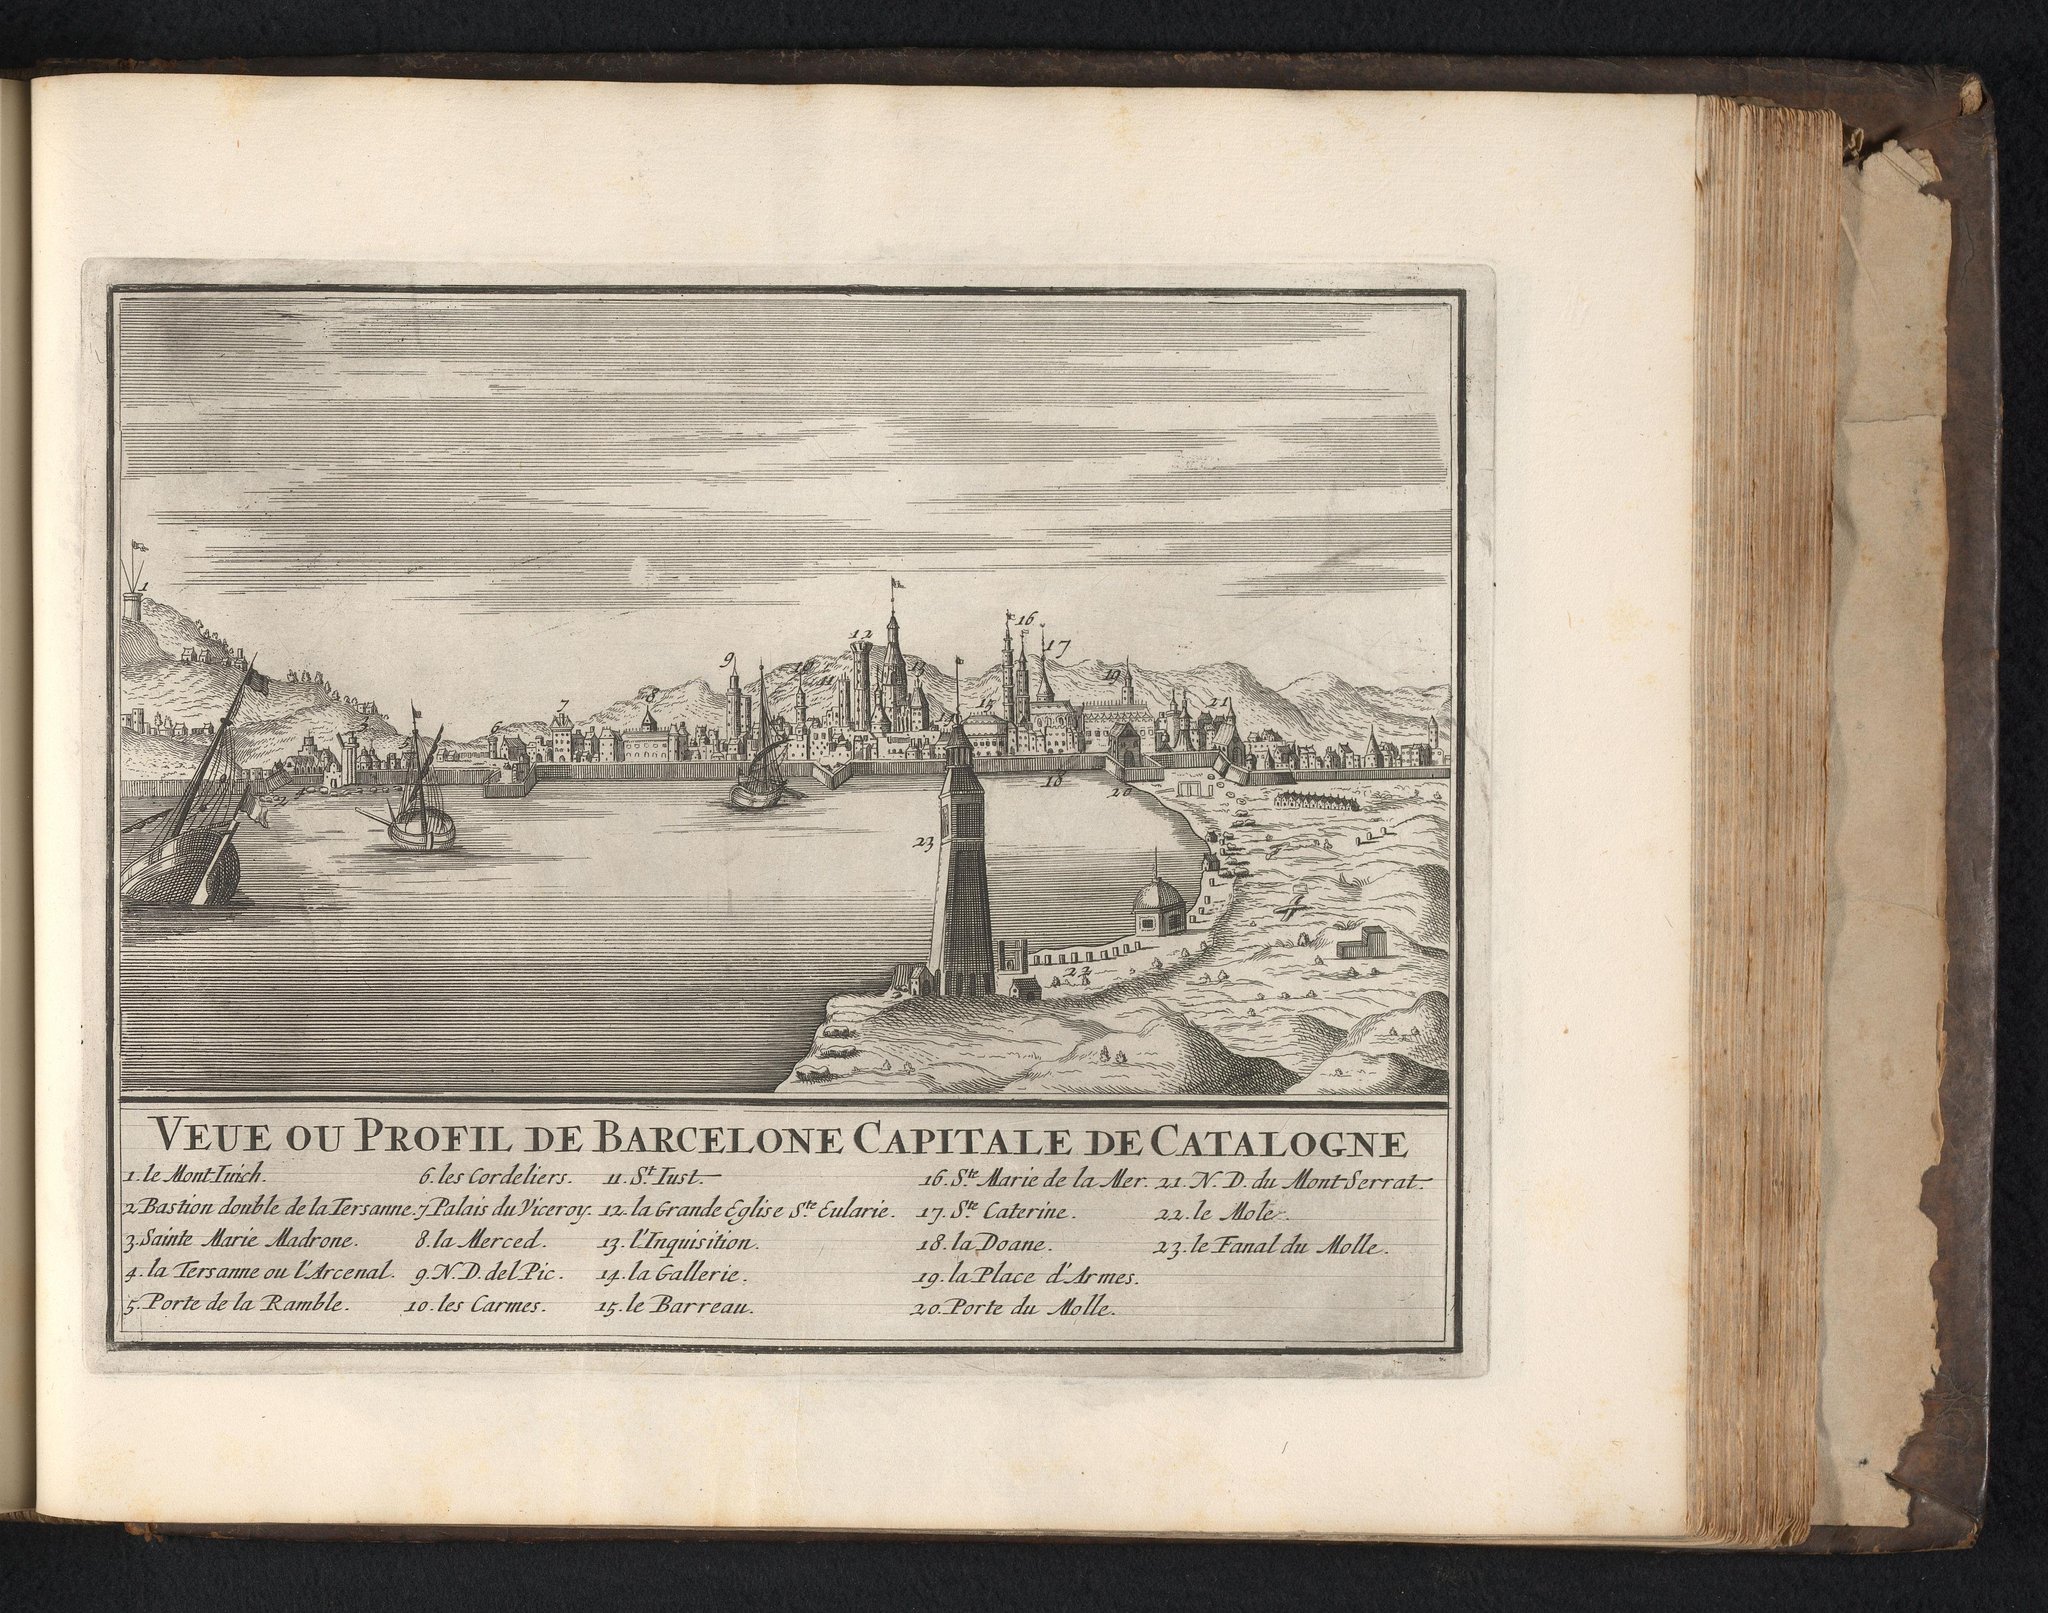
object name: print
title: Veue ou Profil de Barcelone Capitale de Catalogne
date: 1695-1697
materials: paper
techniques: etching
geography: paris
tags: barcelona, negenjarige oorlog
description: Gezicht op de Spaanse stad Barcelona. Onderdeel van het achtste deel (1697) van het prentwerk waarin gebundeld zijn de acht delen van Les forces de l'Europe uitgegeven tussen 1693-1697. Het prentwerk bestaat uit 175 platen met plannen (afkomstig van Sébastien Le Prestre, Seigneur de Vauban) van vermaarde sterke steden en vestingen in de Negenjarige Oorlog. Titel en opschriften in het Frans.